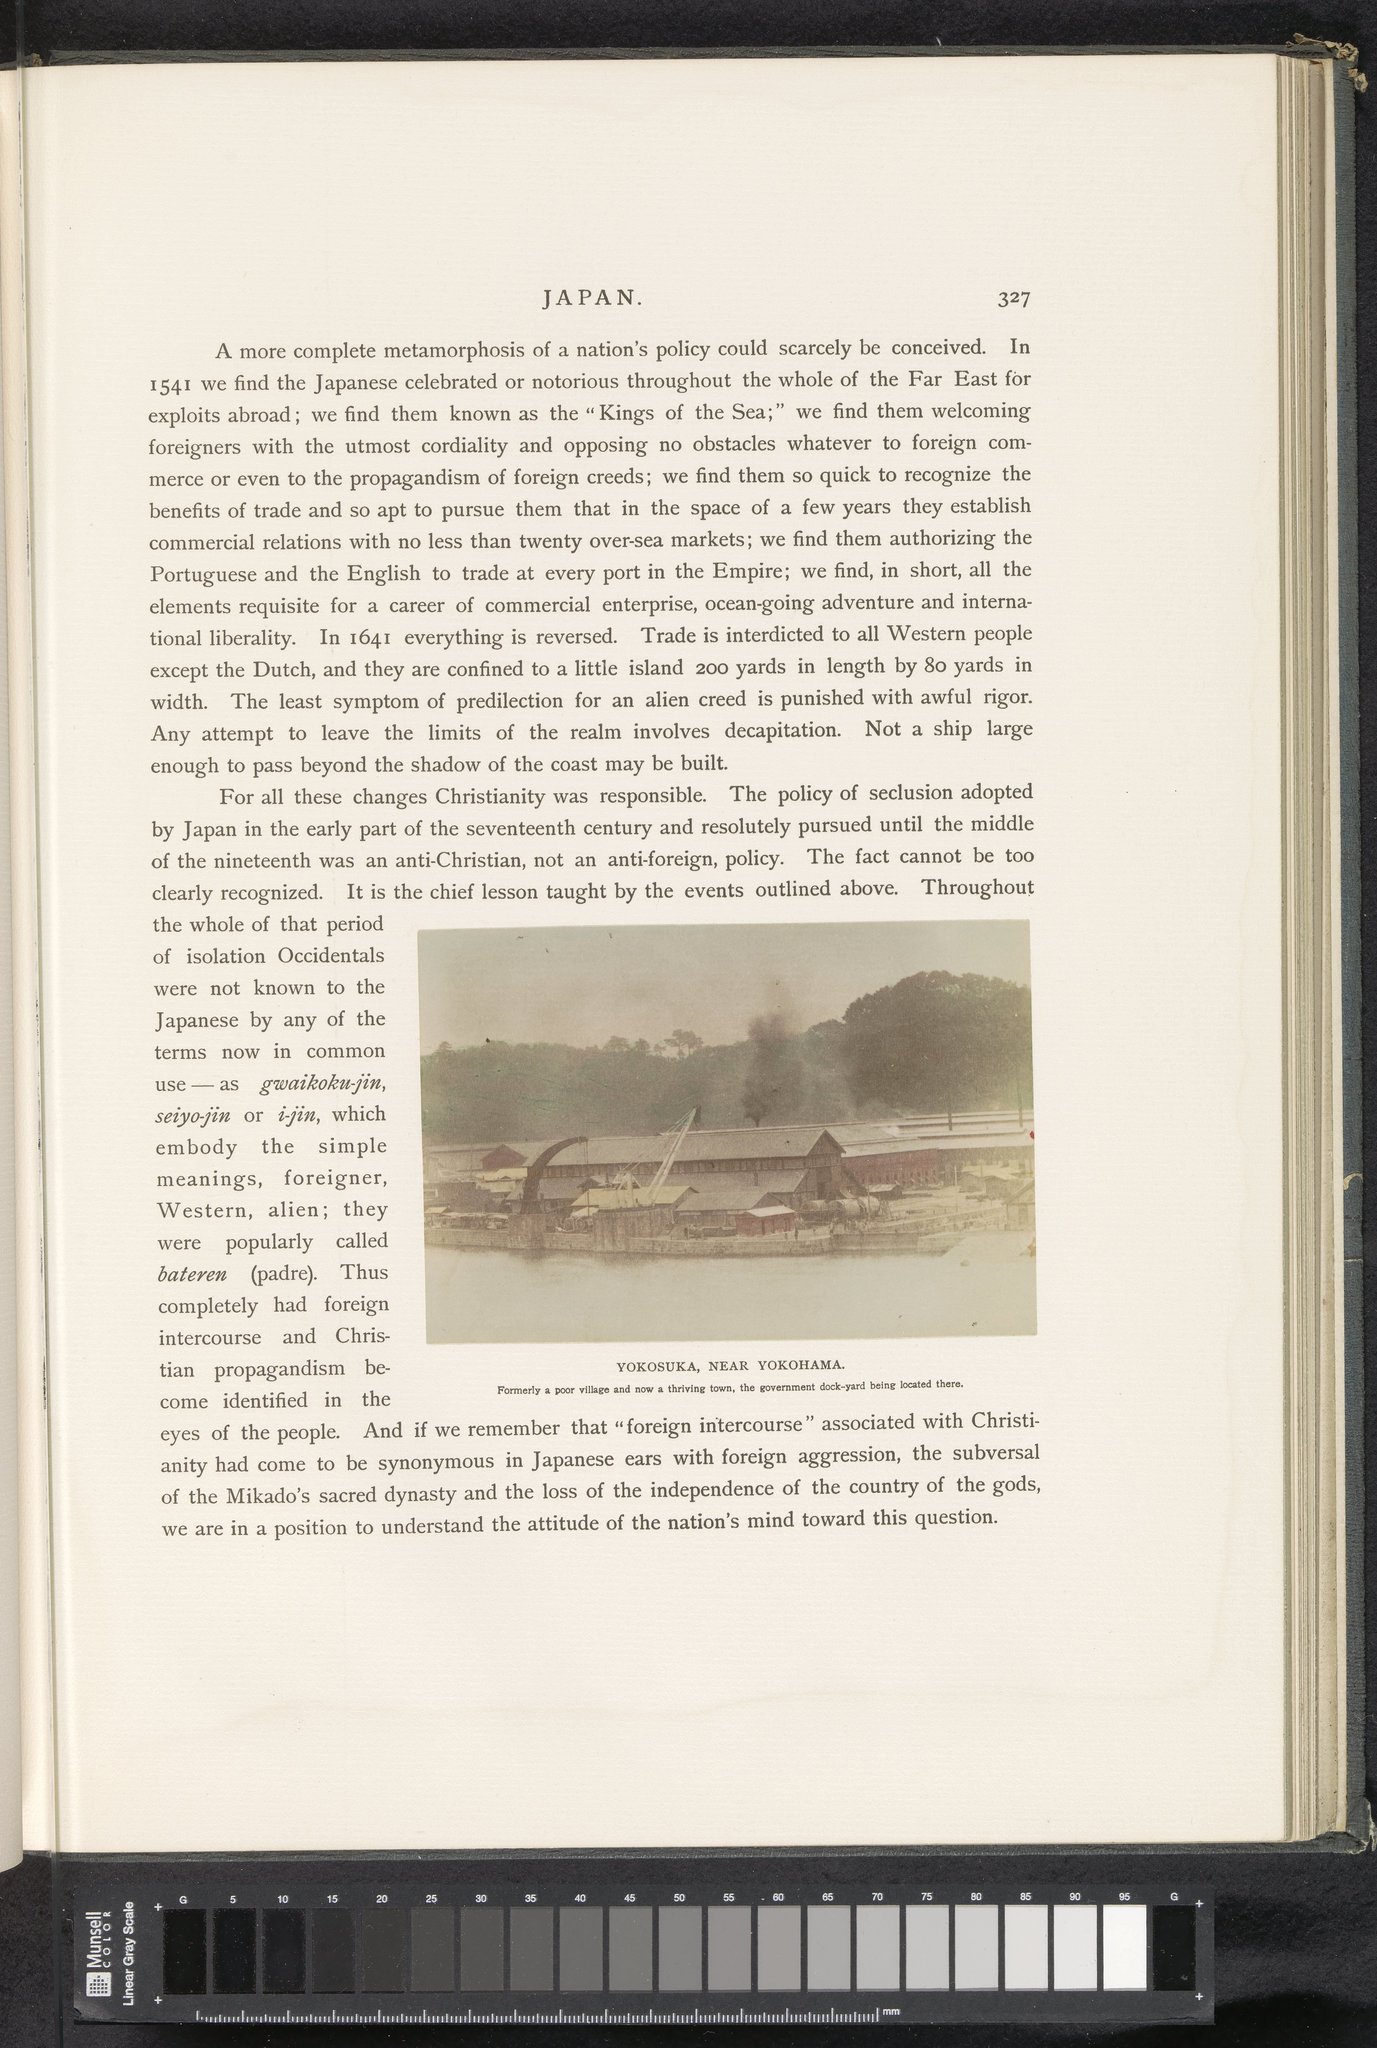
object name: page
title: Yokosuka, near Yokohama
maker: Anonymous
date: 1887-1897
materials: photographic support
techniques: albumen print, hand coloring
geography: japan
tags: shipyard, shipdock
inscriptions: inscription: ‘Formerly a poor village and now a thriving town, the government dock-yard being located there.’